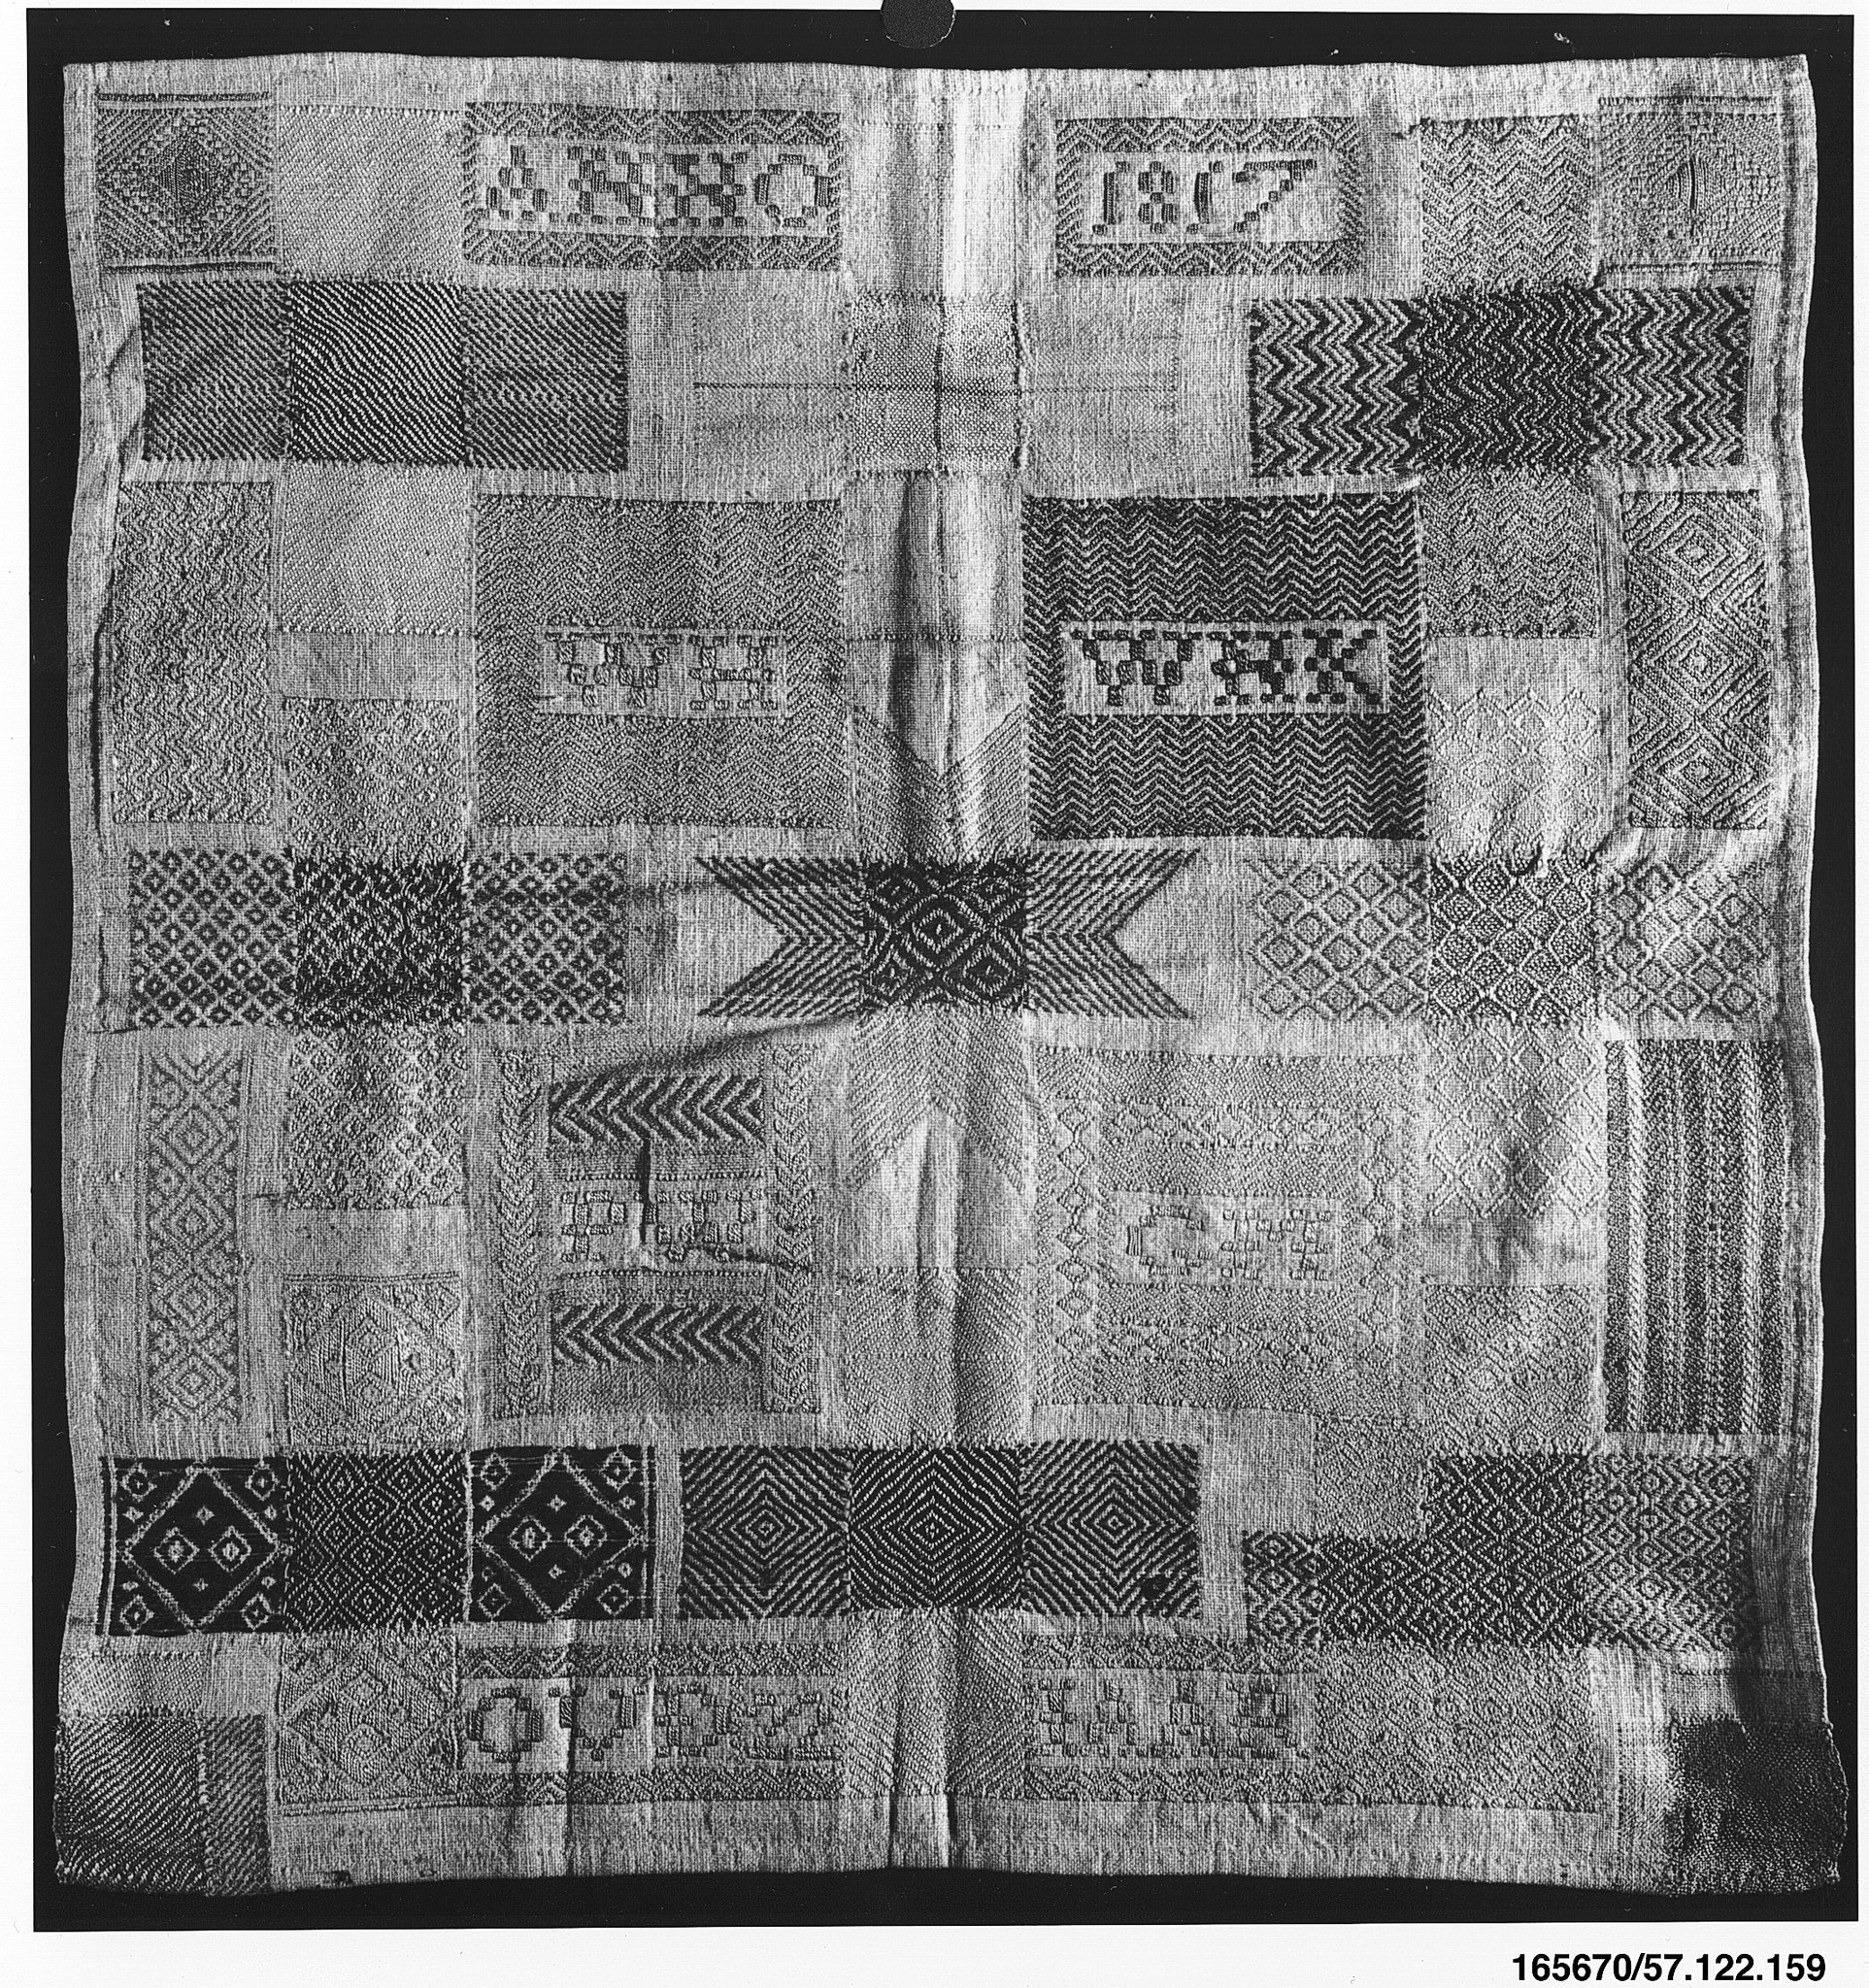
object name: sampler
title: Embroidered darning sampler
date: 1817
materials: cotton, silk